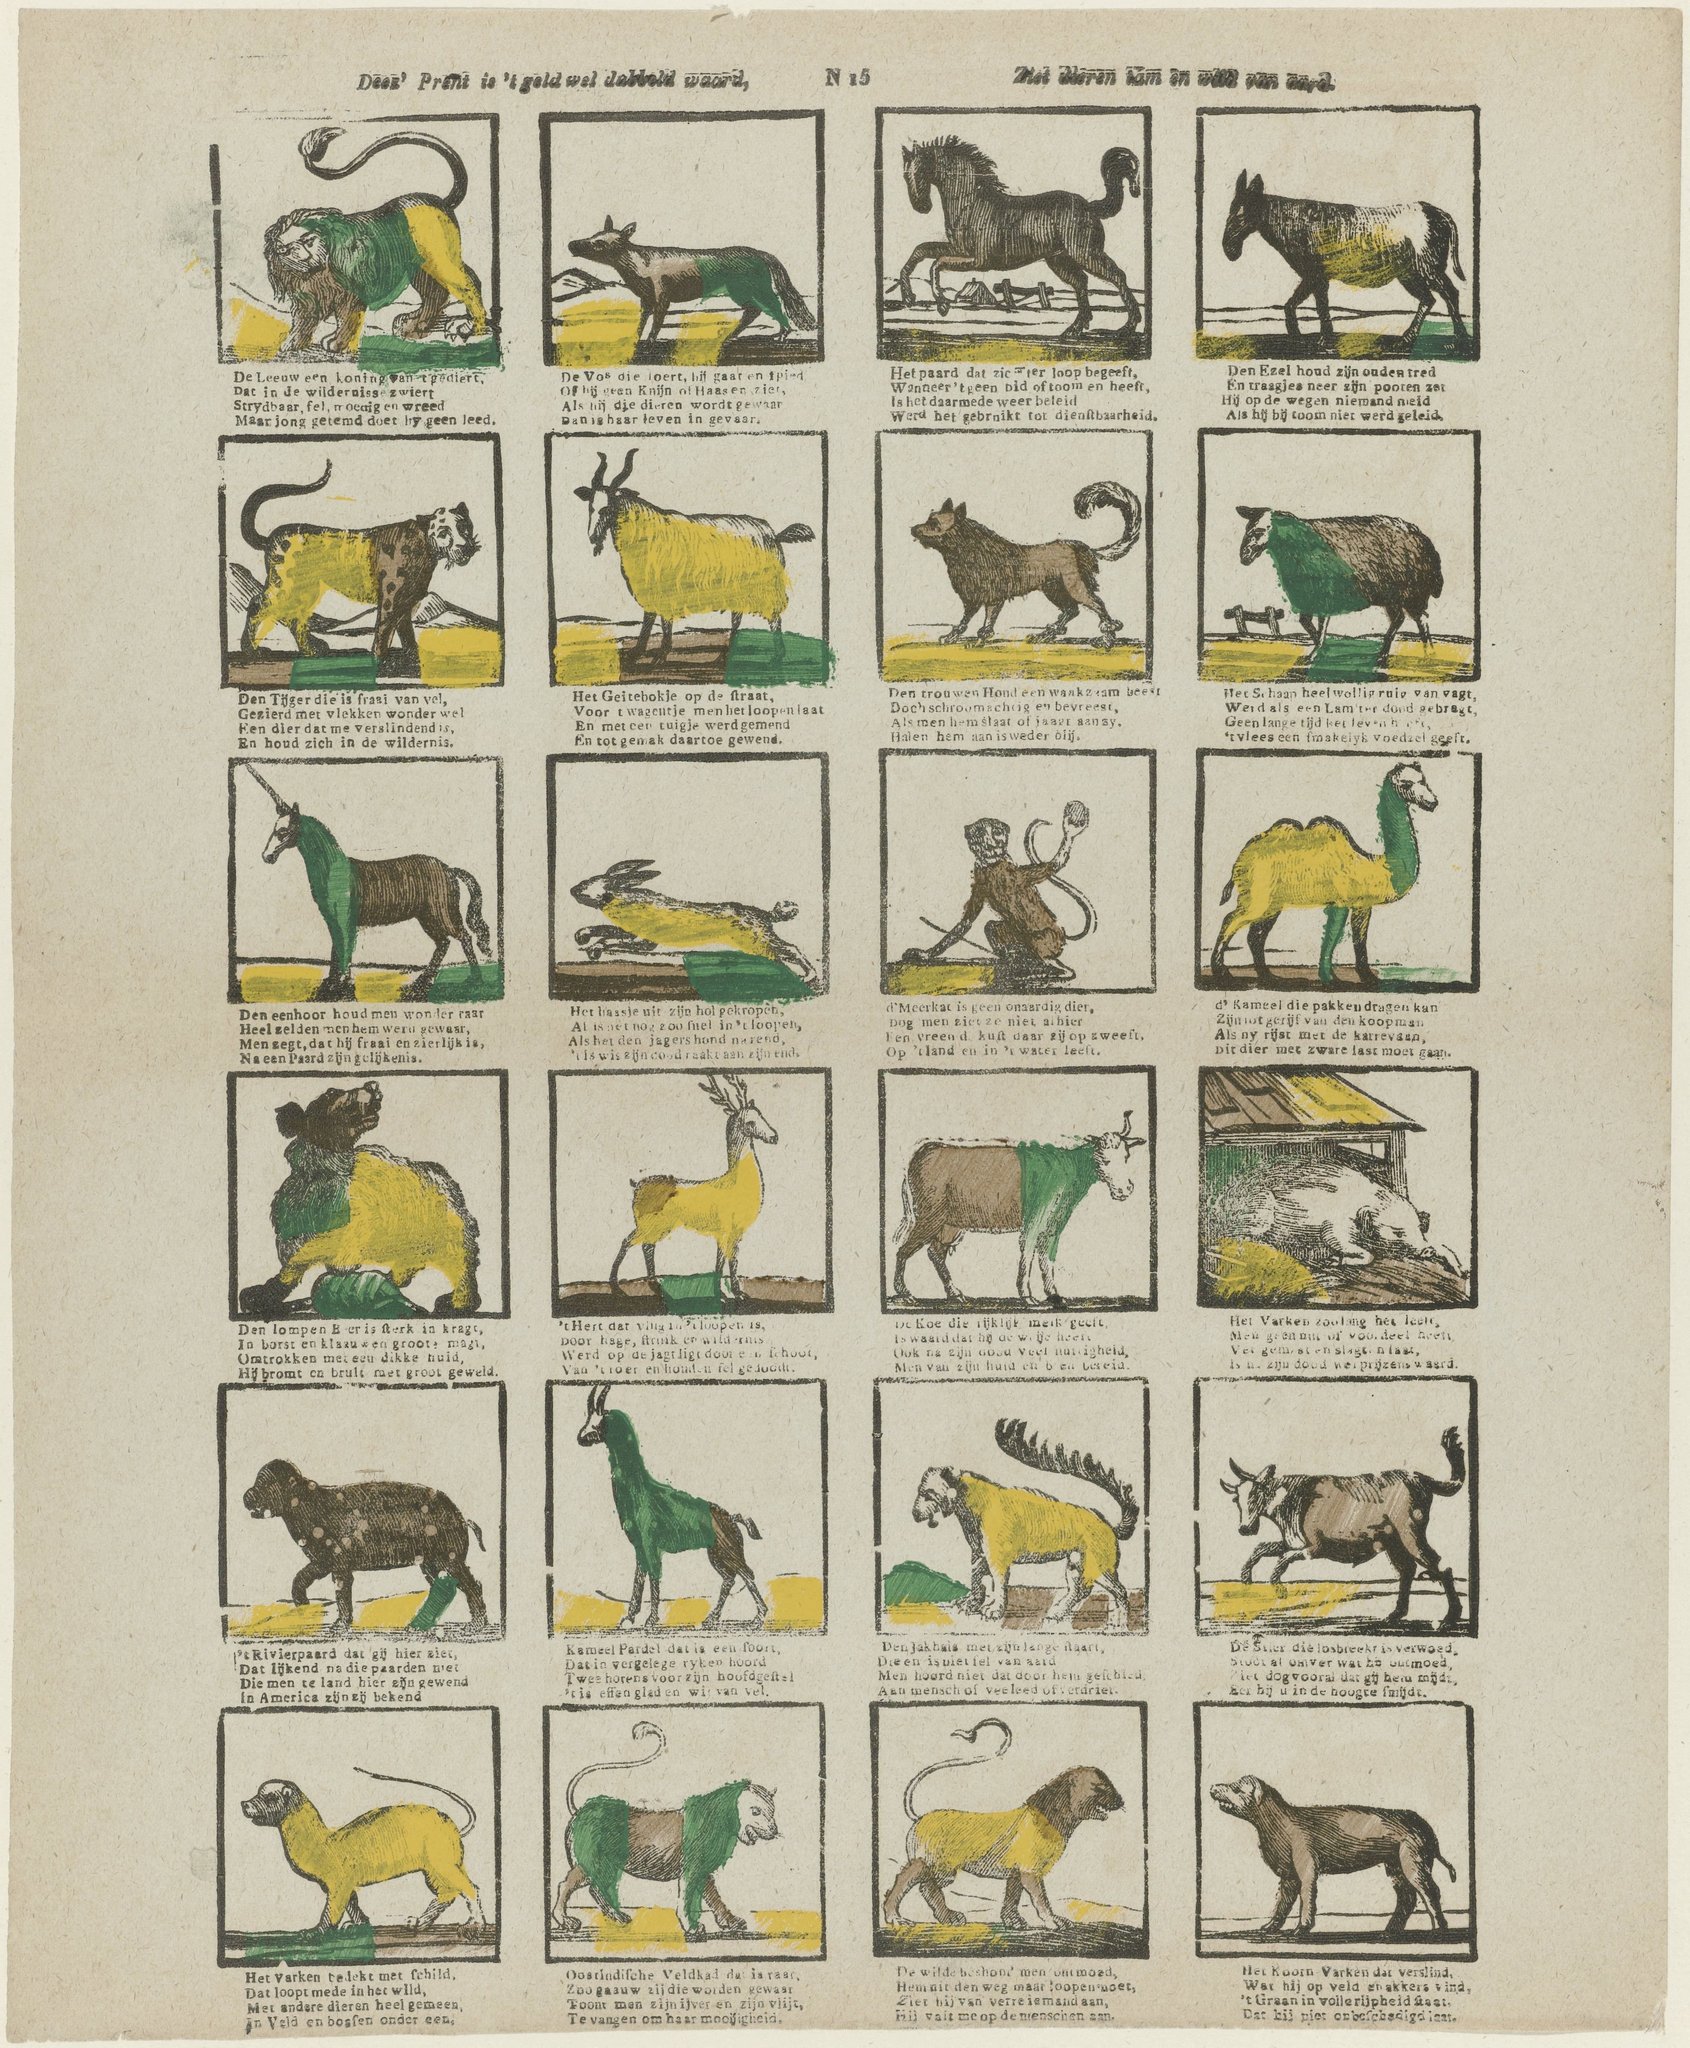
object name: print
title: Deez'prent is 't geld wel dubbeld waard, / Ziet dieren tam en wild van aard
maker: Anonymous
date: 1856-1900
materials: paper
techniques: colour, letterpress printing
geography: turnhout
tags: bull, unicorn, animals, horse, beasts of prey, predatory animals: lion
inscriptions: collector's mark: Lugt 2760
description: Blad met 24 voorstellingen van dieren, zoals een leeuw, een pard, een hond en een stier. Onder elke voorstelling een vierregelig vers. Genummerd midden boven: N 15.